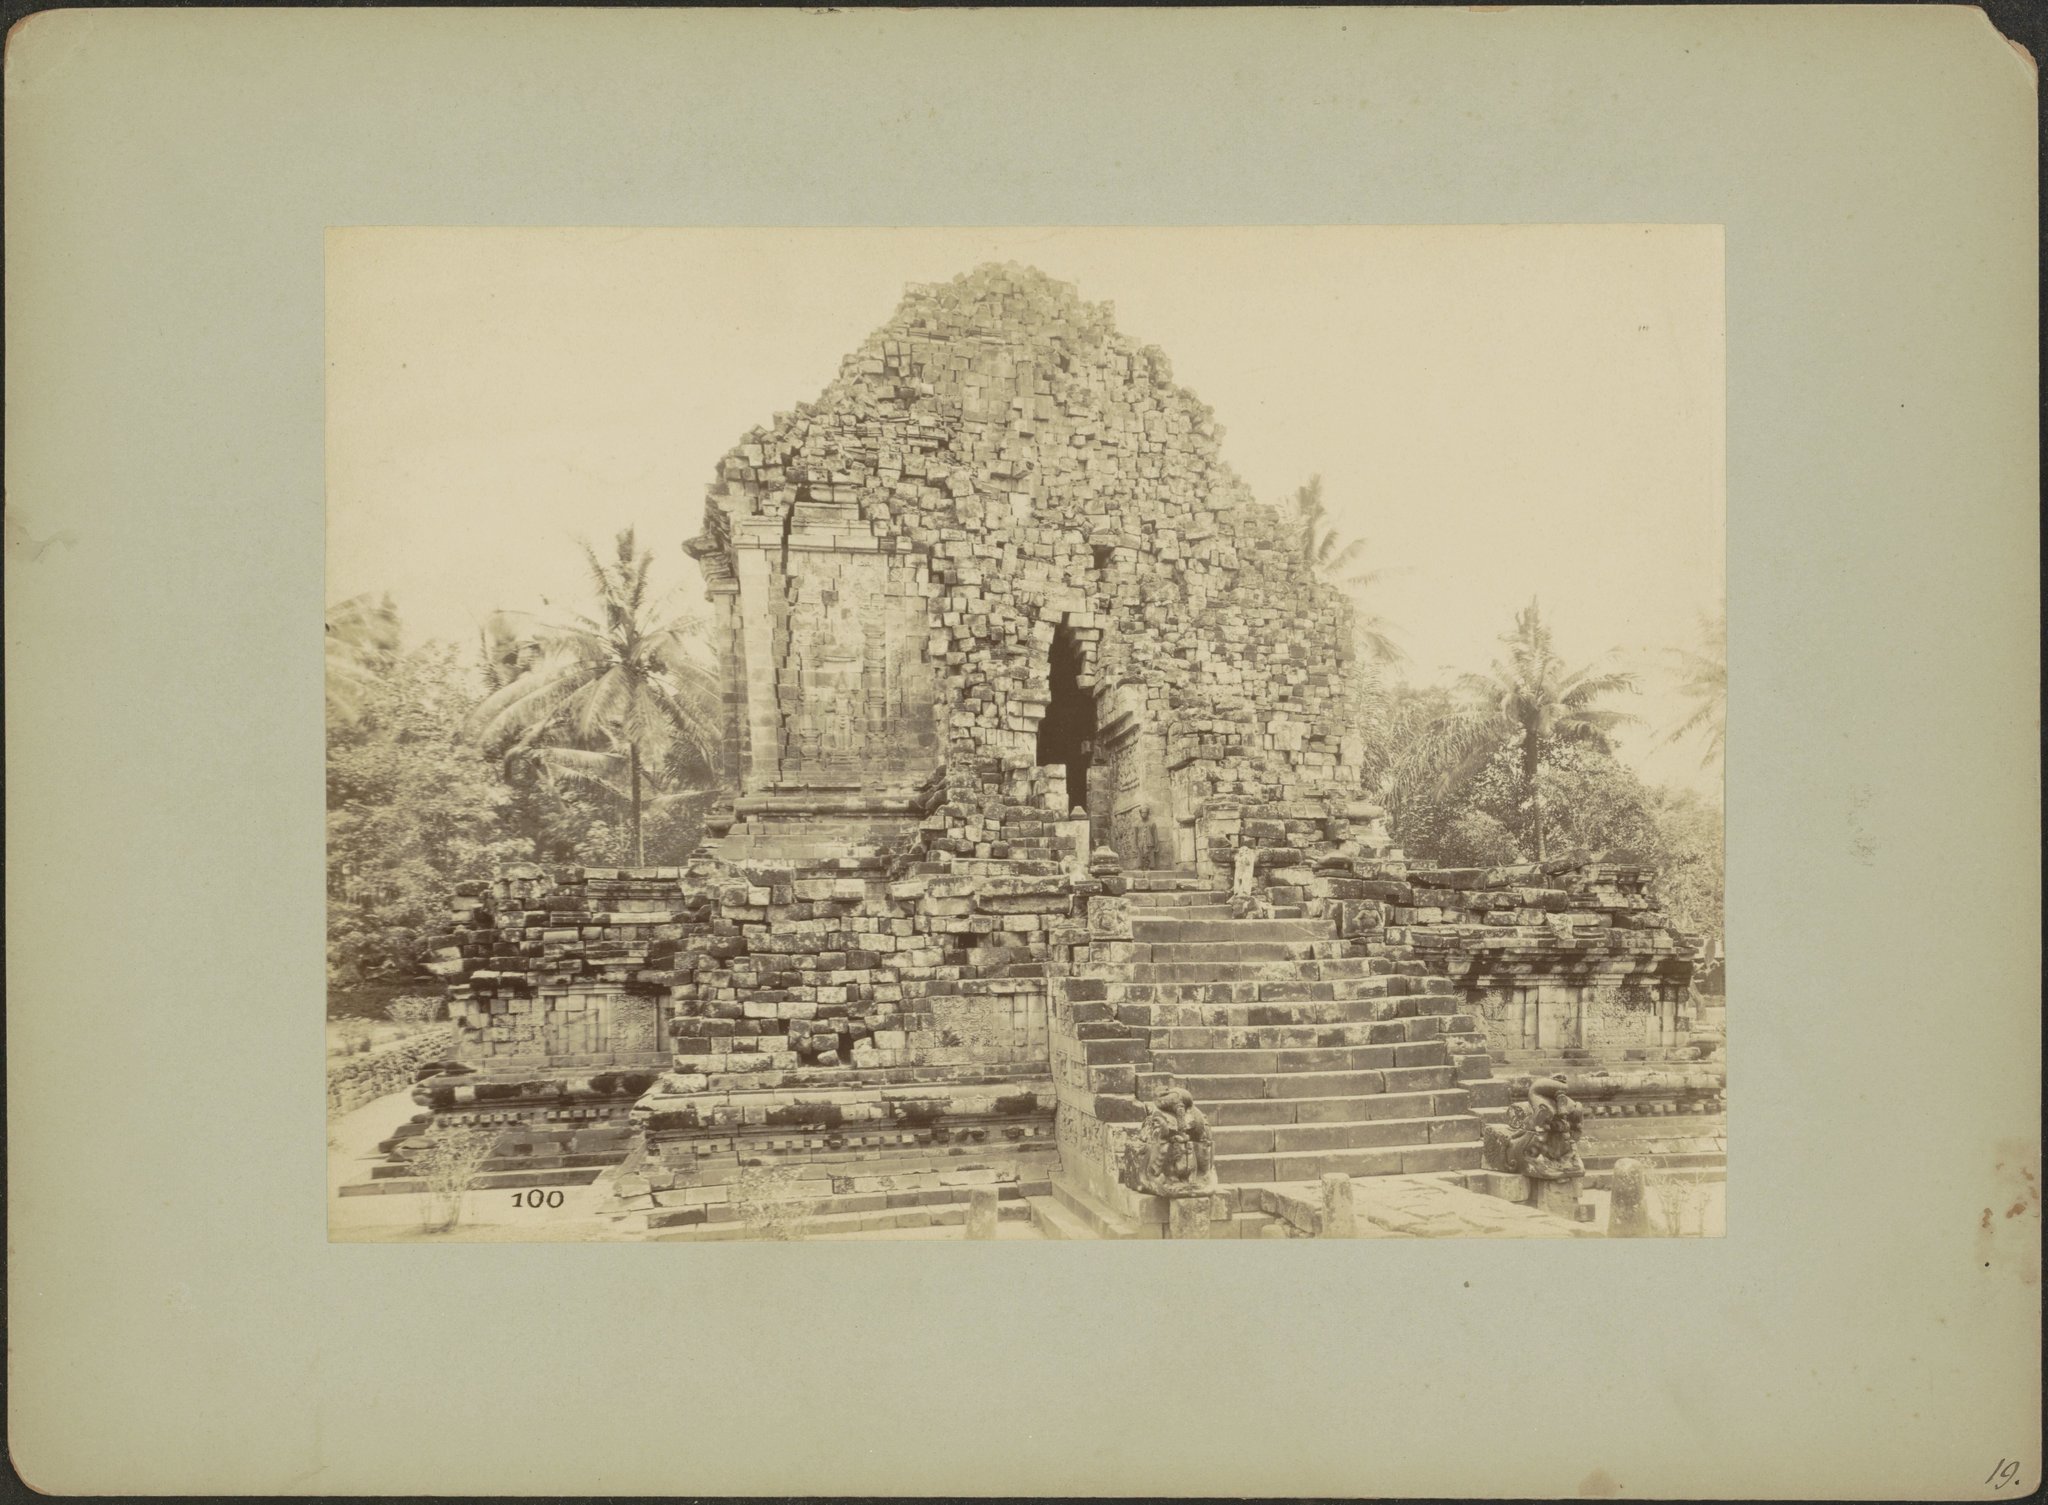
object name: photograph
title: Boeddhistische tempel (mendoet) op Java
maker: Anonymous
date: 1870-1910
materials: cardboard, paper, photographic support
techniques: albumen print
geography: java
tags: temple, shrine ~ hinduism, buddhism, jainism, java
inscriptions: inscription: ‘Mendoet tusschen Magelang en Djocja.’, number: ‘100’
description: Onderdeel van Reisalbum met foto's van bezienswaardigheden in Marseille, Port Said, Aden, Bombay, Colombo, Singapore en Nederlands-Indië.